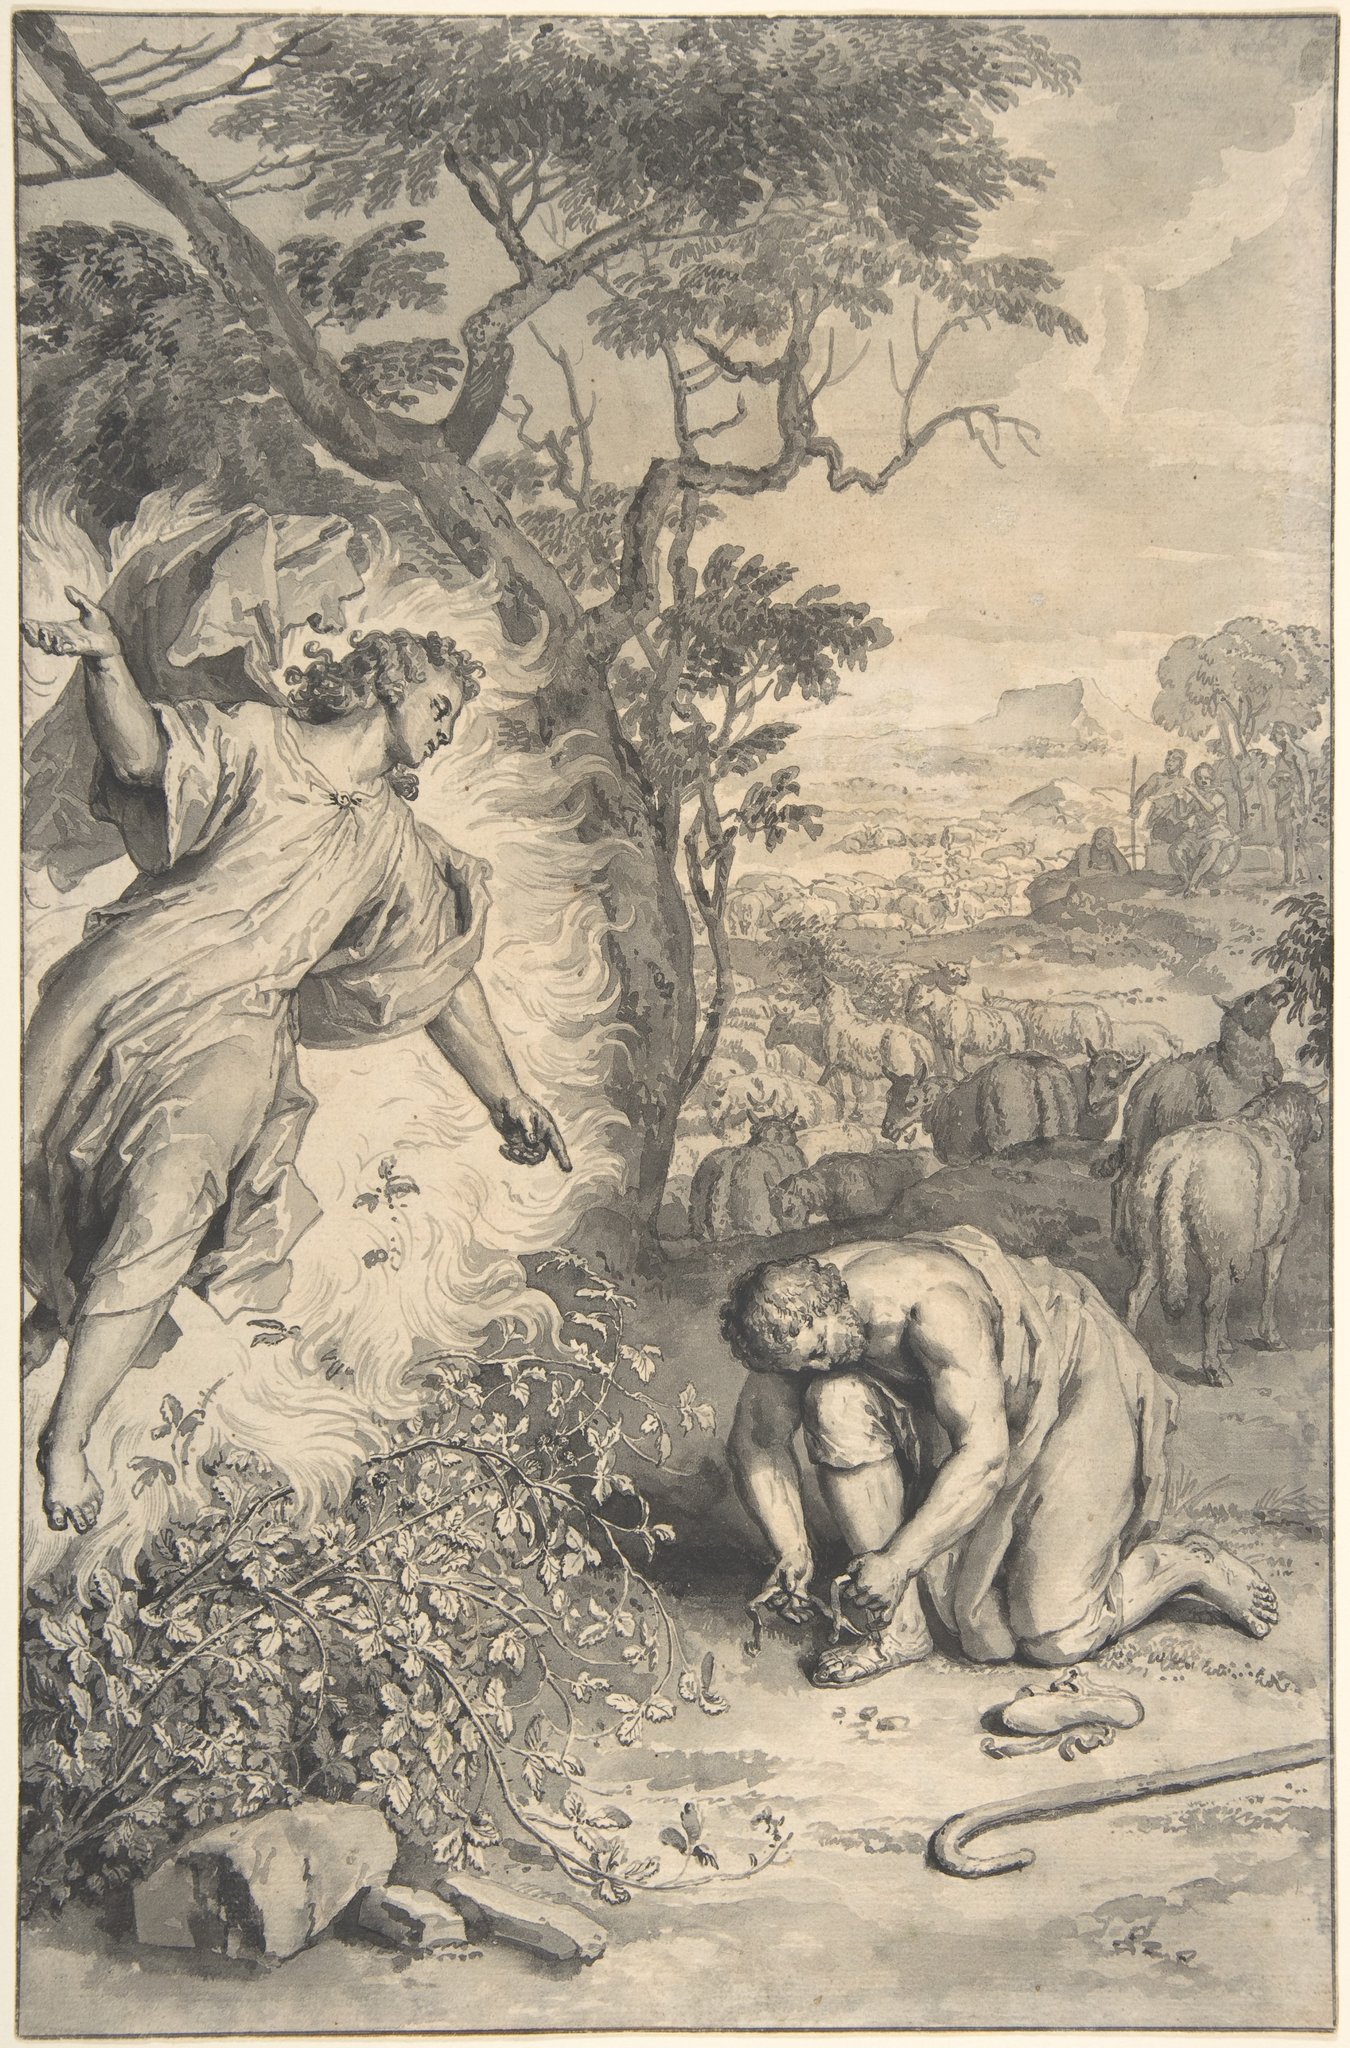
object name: drawing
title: Moses and the Burning Bush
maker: gerard hoet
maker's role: artist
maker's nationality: dutch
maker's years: 1648-1733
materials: ink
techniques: brush, heightening, pen, wash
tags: sheep,fire,trees,moses